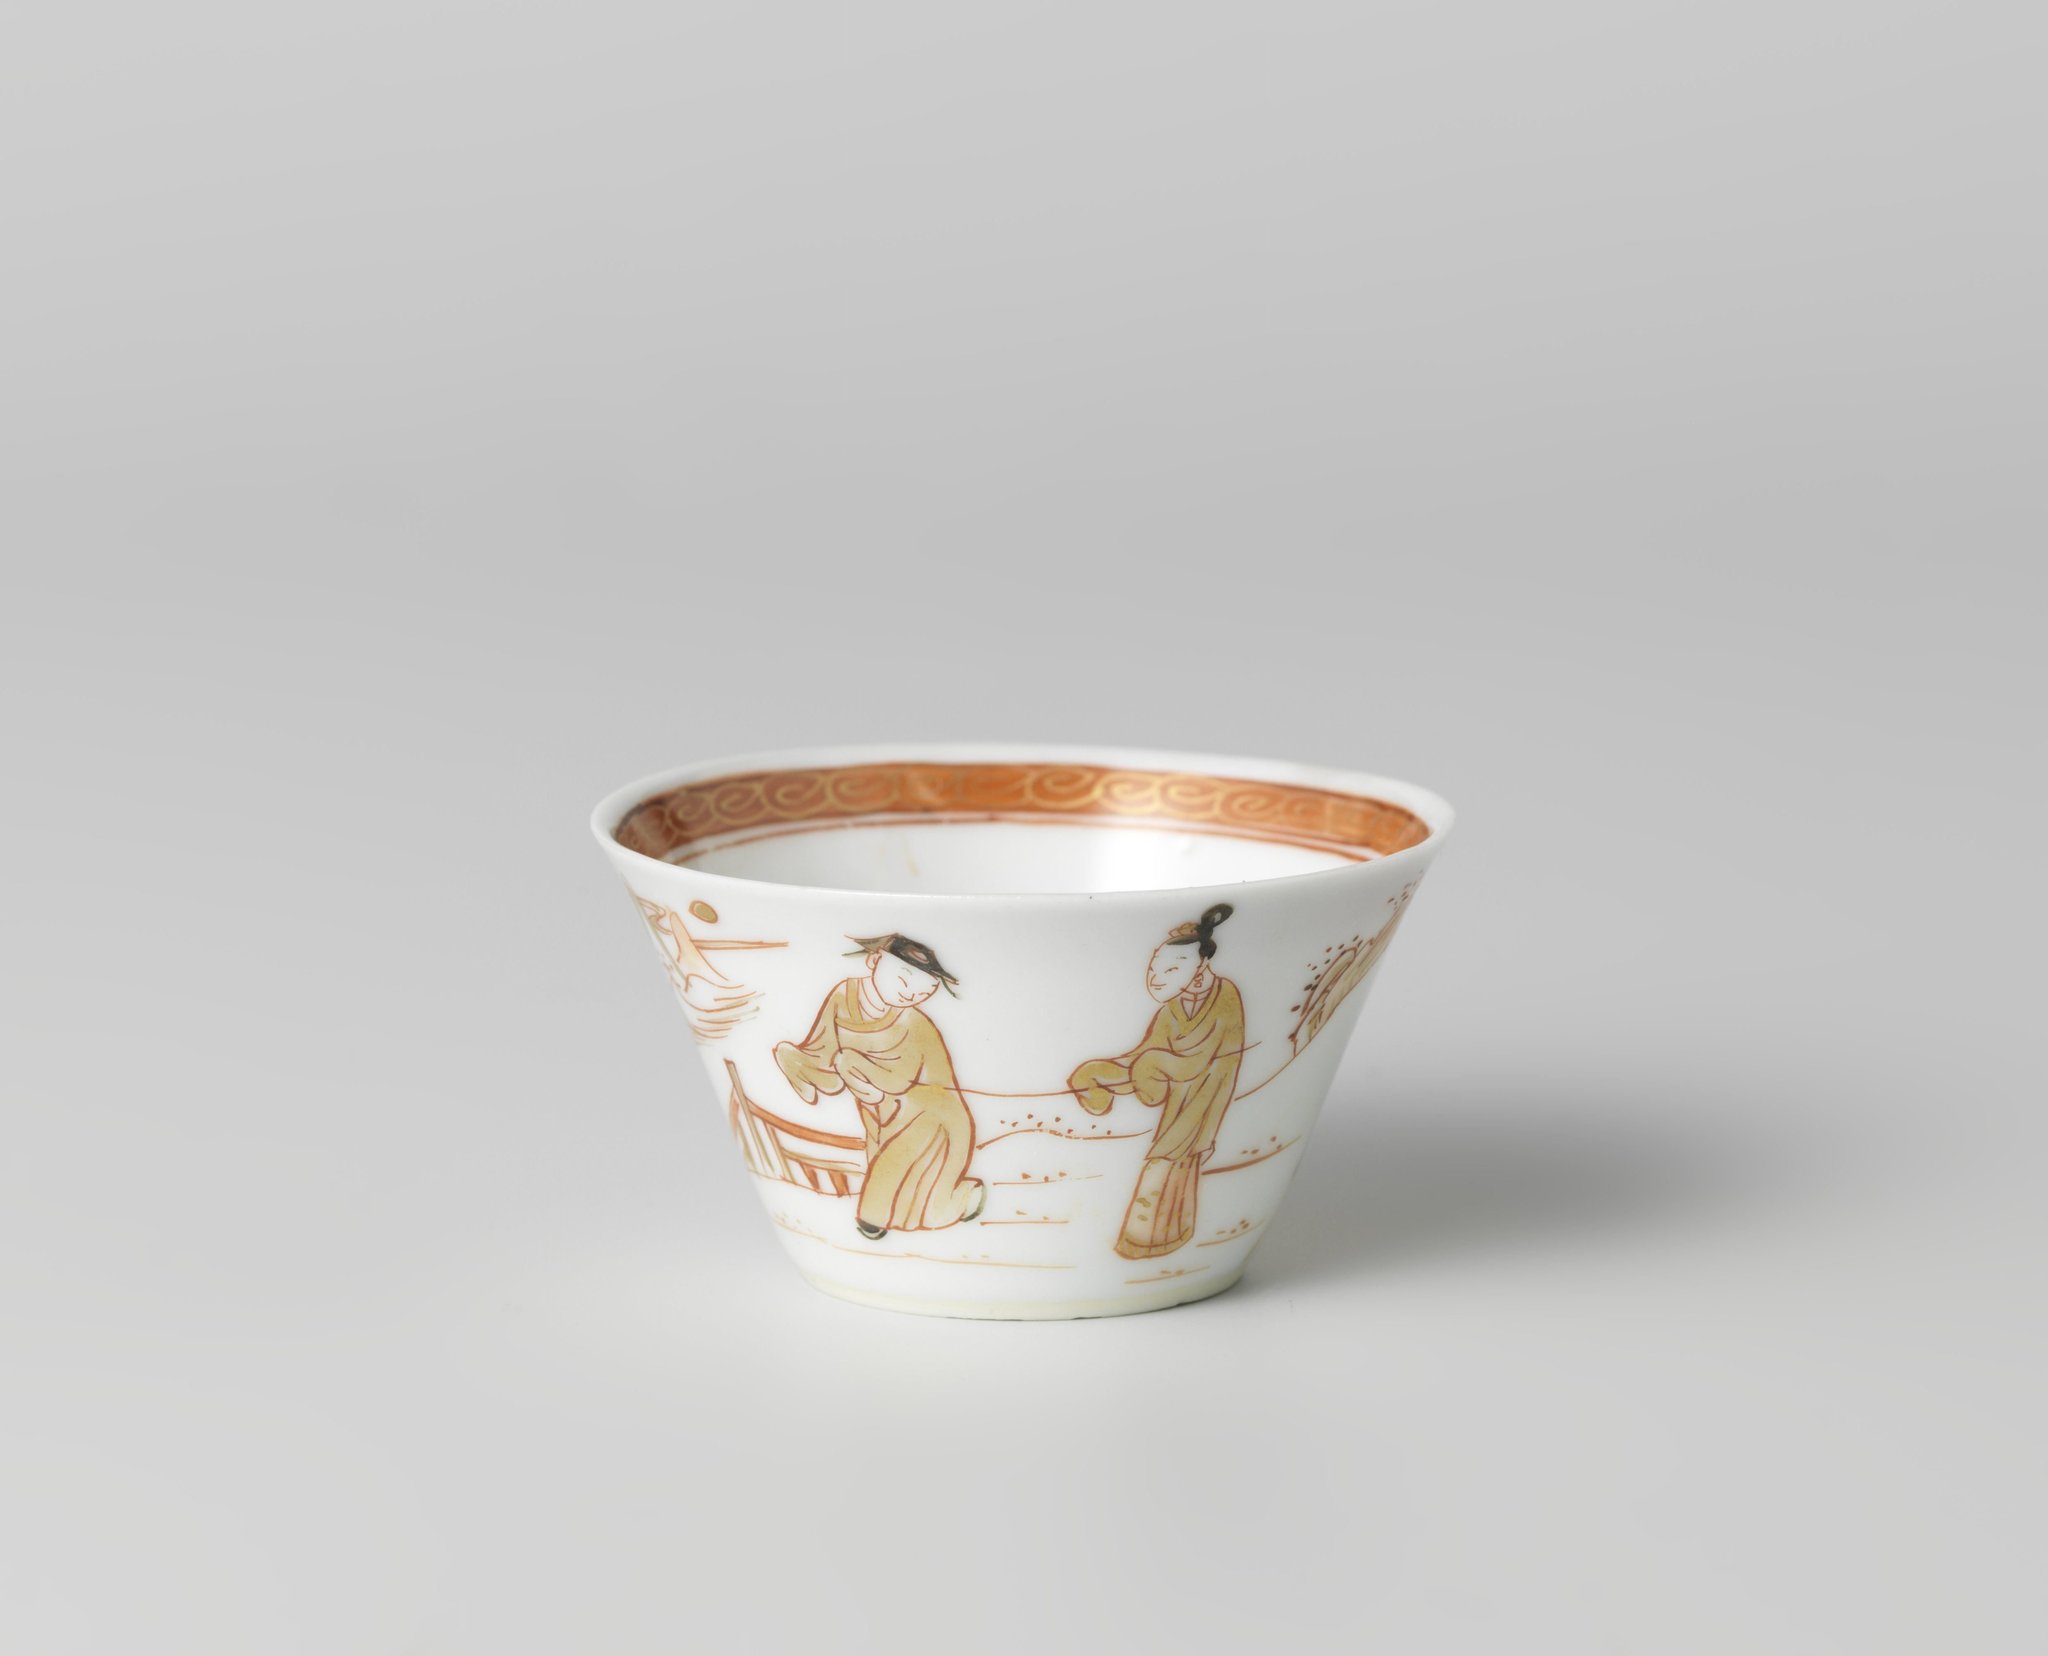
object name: kop en schotel, kop en schotel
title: Cup with two figures in a water landscape and a flowering tree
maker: Anonymous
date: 1700-1724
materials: glaze, gold, paint, porcelain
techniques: firing, gilding, turning, vitrification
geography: china